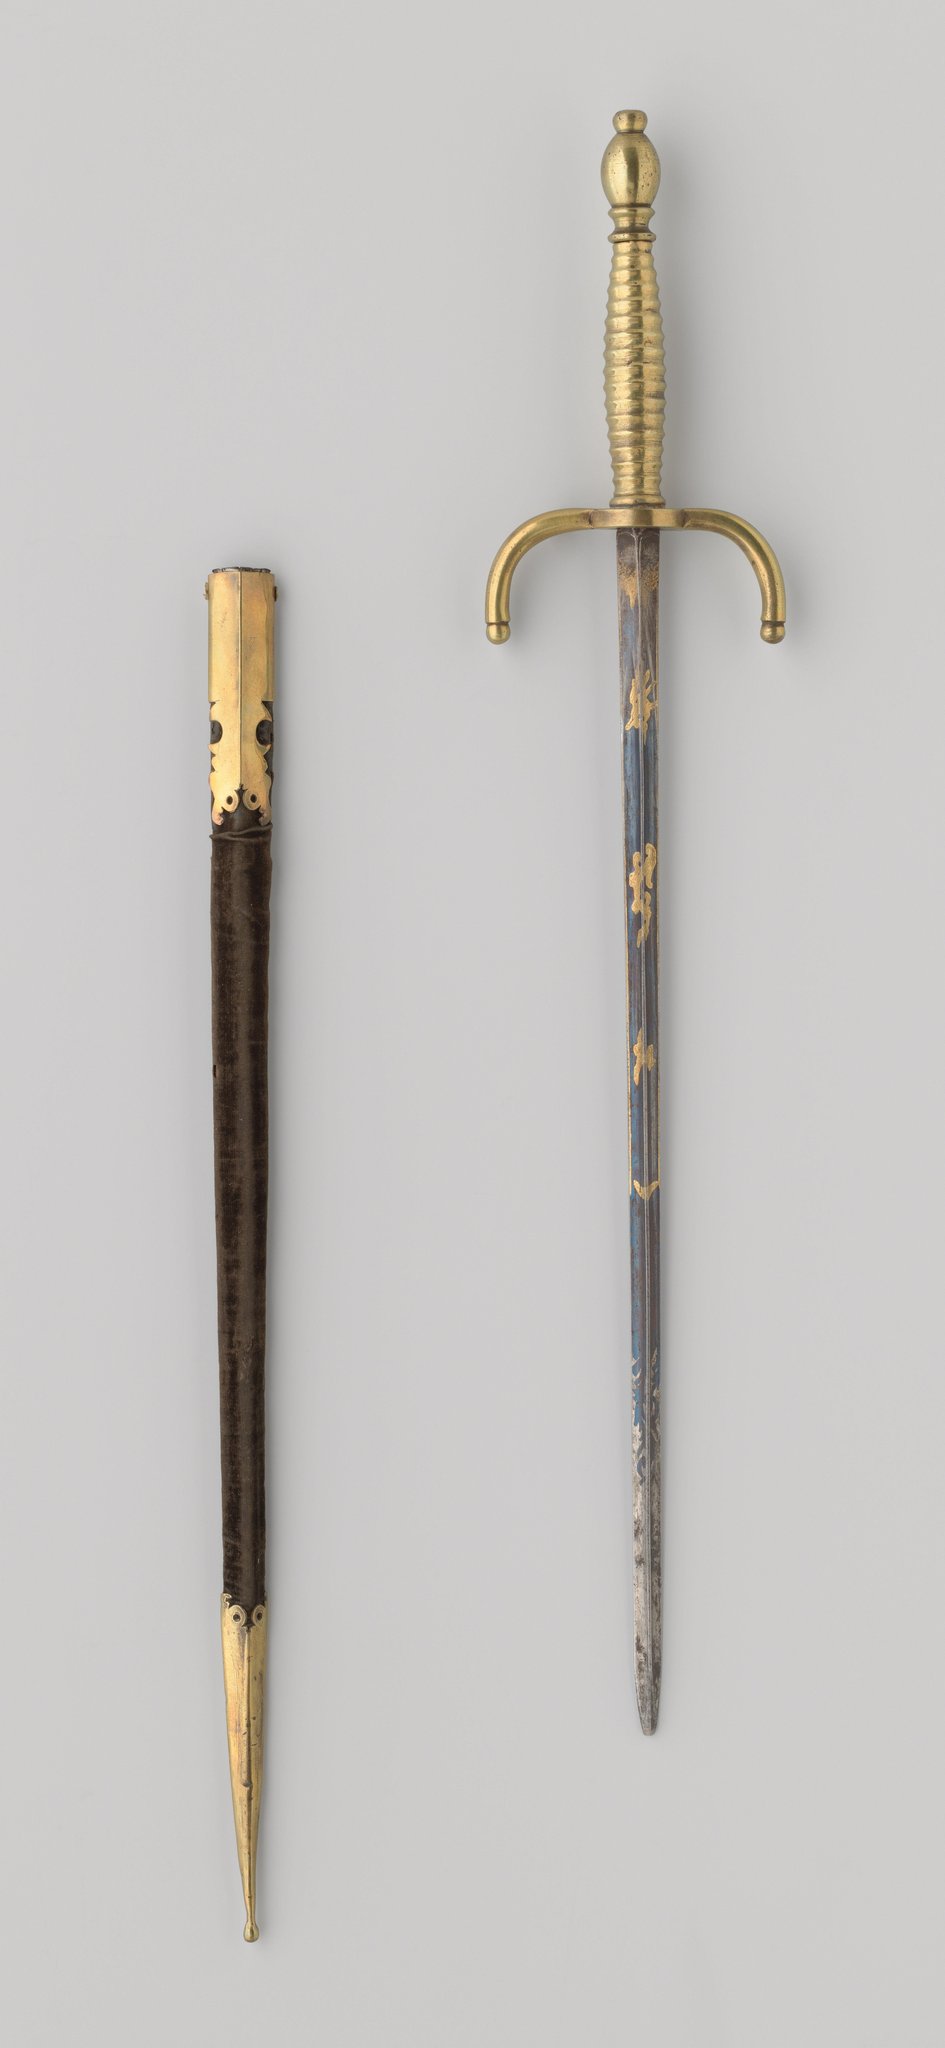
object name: dagger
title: Dolk in zwarte leren schede met kwast van zilvergalon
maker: Anonymous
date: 1800-1950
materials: copper, iron, leather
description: Dolk met driehoekige geblauwde kling. Het gevest is geribd en heeft een bolle greepknop. De schede is van zwart leer en heeft een koperen trechter.